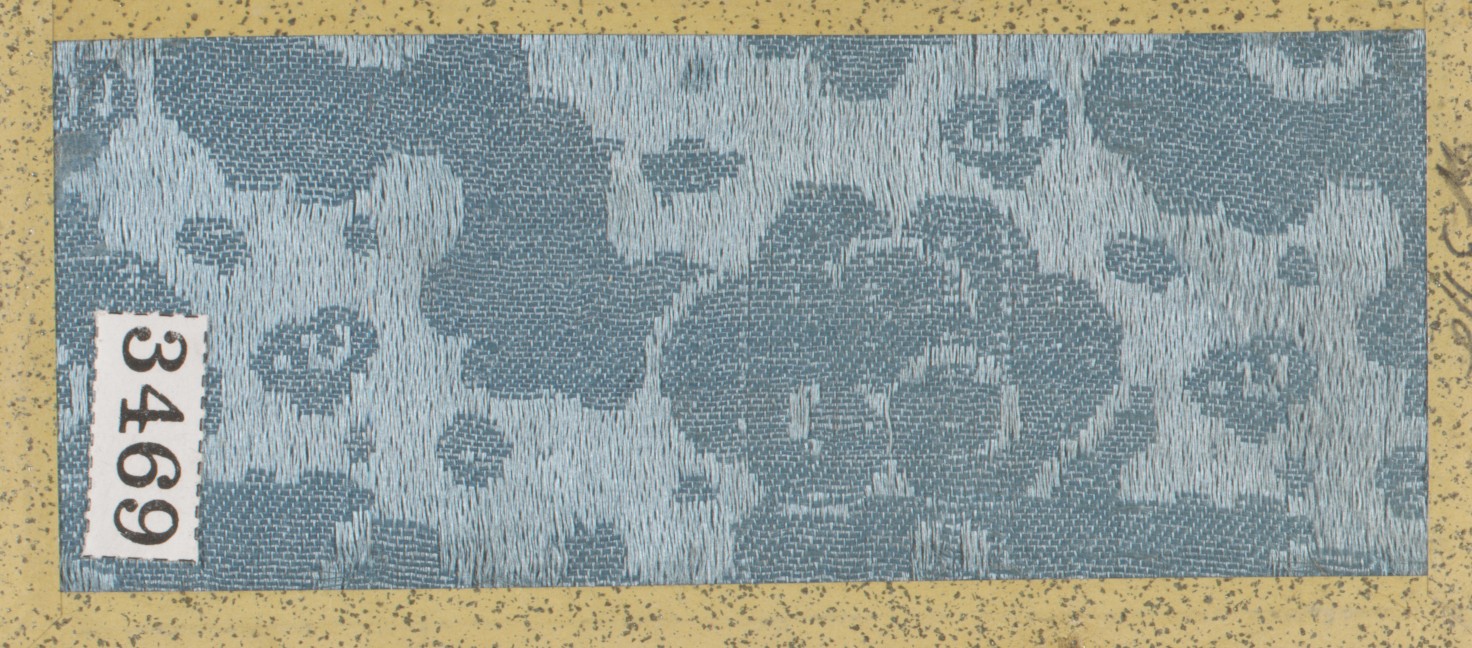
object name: sample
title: Textile Sample from Sample Book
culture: japanese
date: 1801-1900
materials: silk